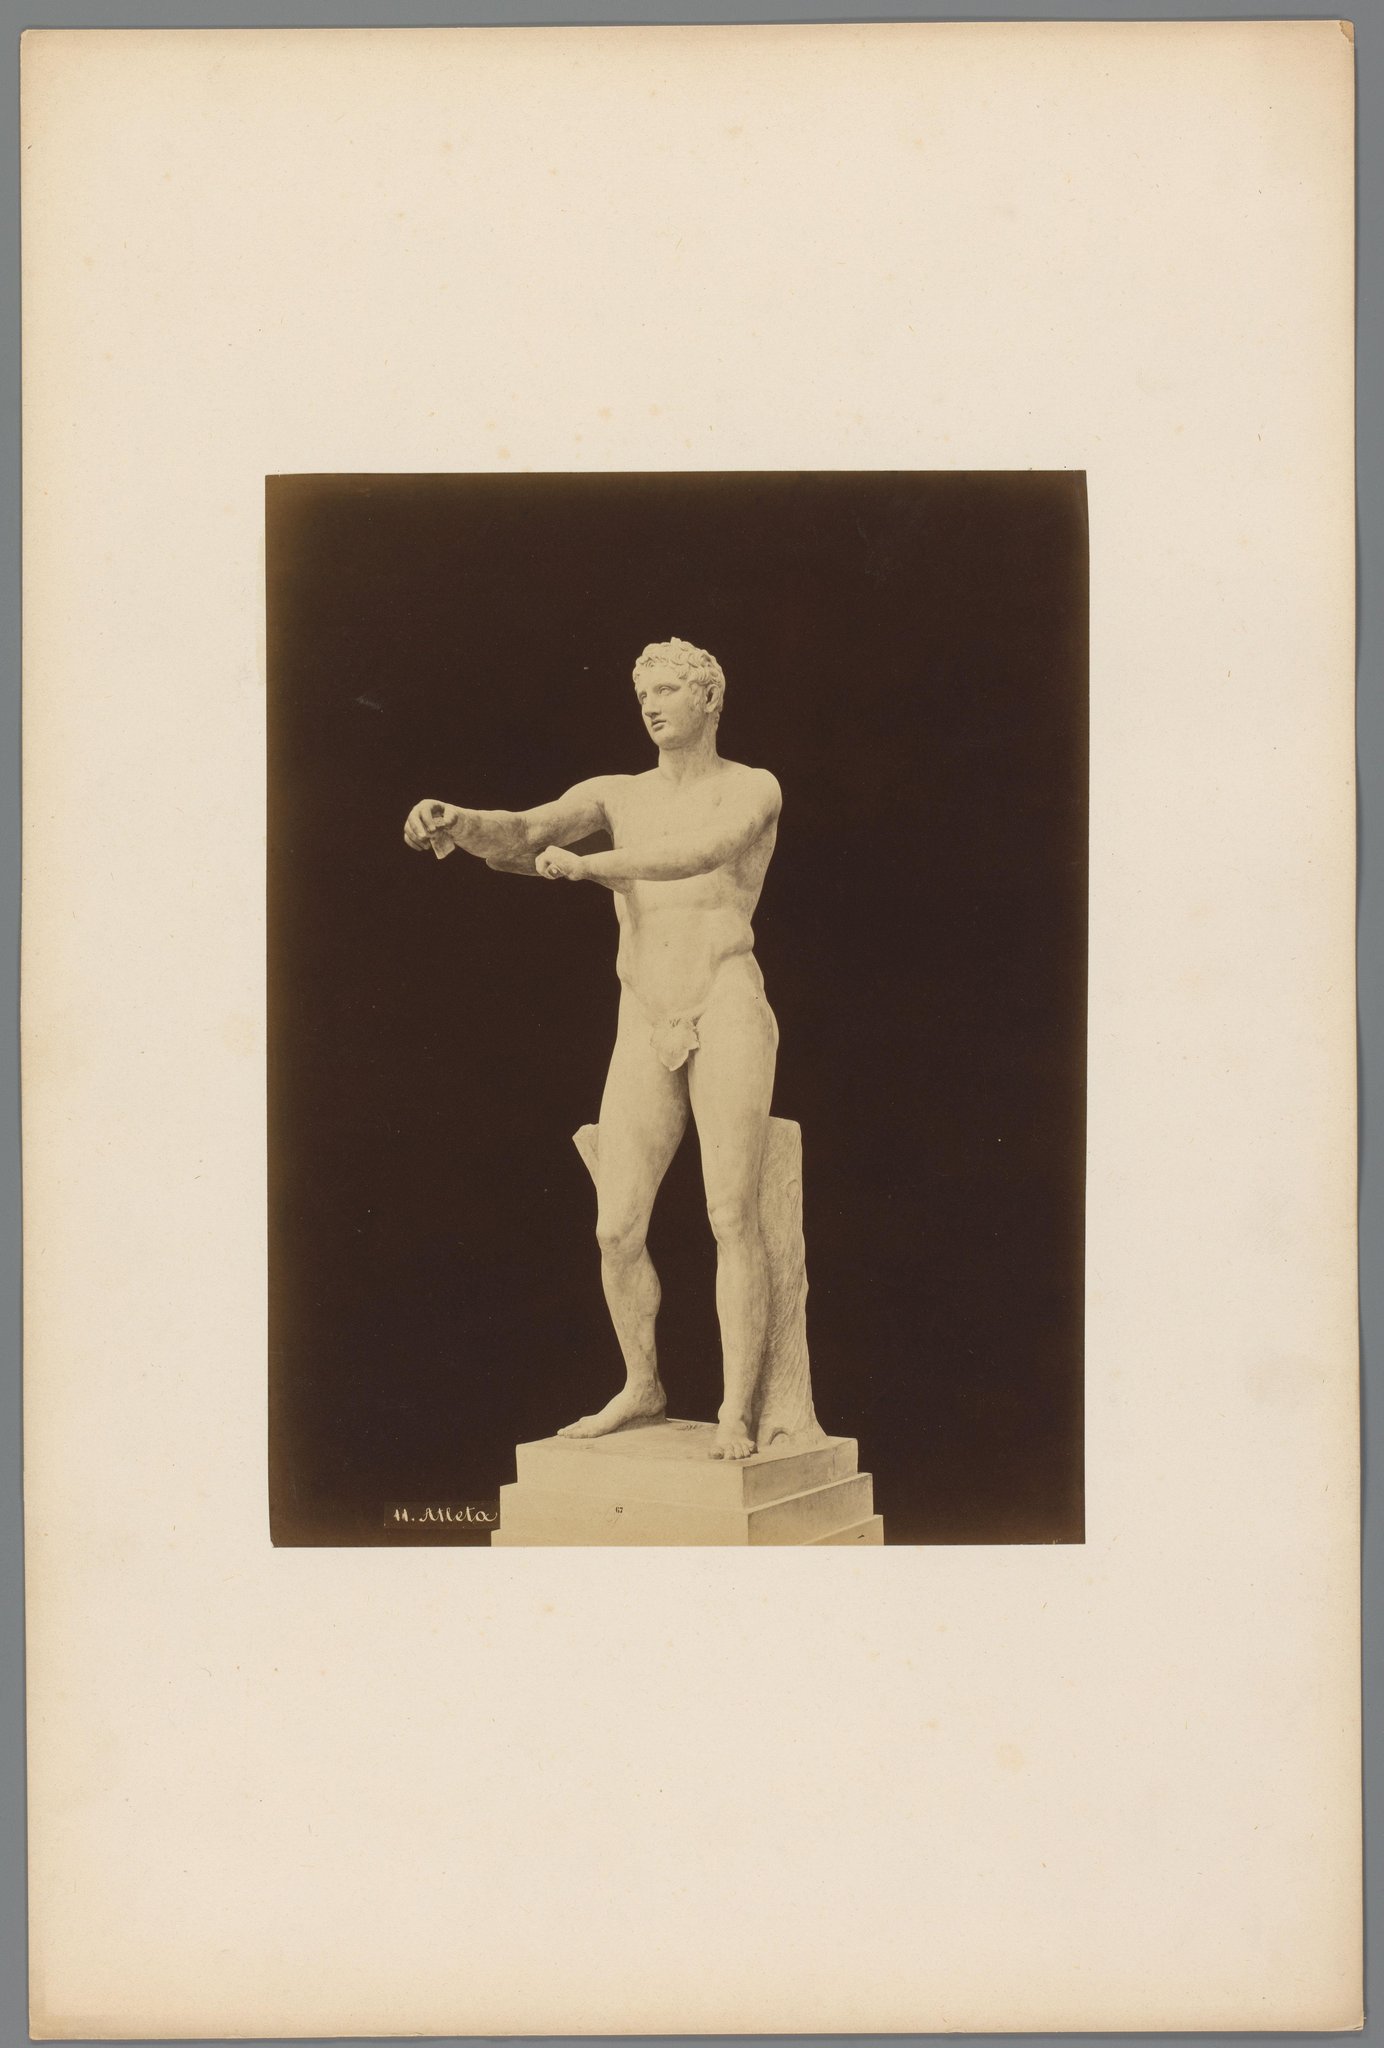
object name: photograph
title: Atleta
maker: Anonymous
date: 1851-1900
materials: cardboard, paper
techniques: albumen print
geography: vatican city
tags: piece of sculpture, reproduction of a piece of sculpture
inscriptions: number: ‘11.’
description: Een apoxymenos is een atleet die het zweet en stof van zijn lichaam schraapt waarna hij kan gaan baden.